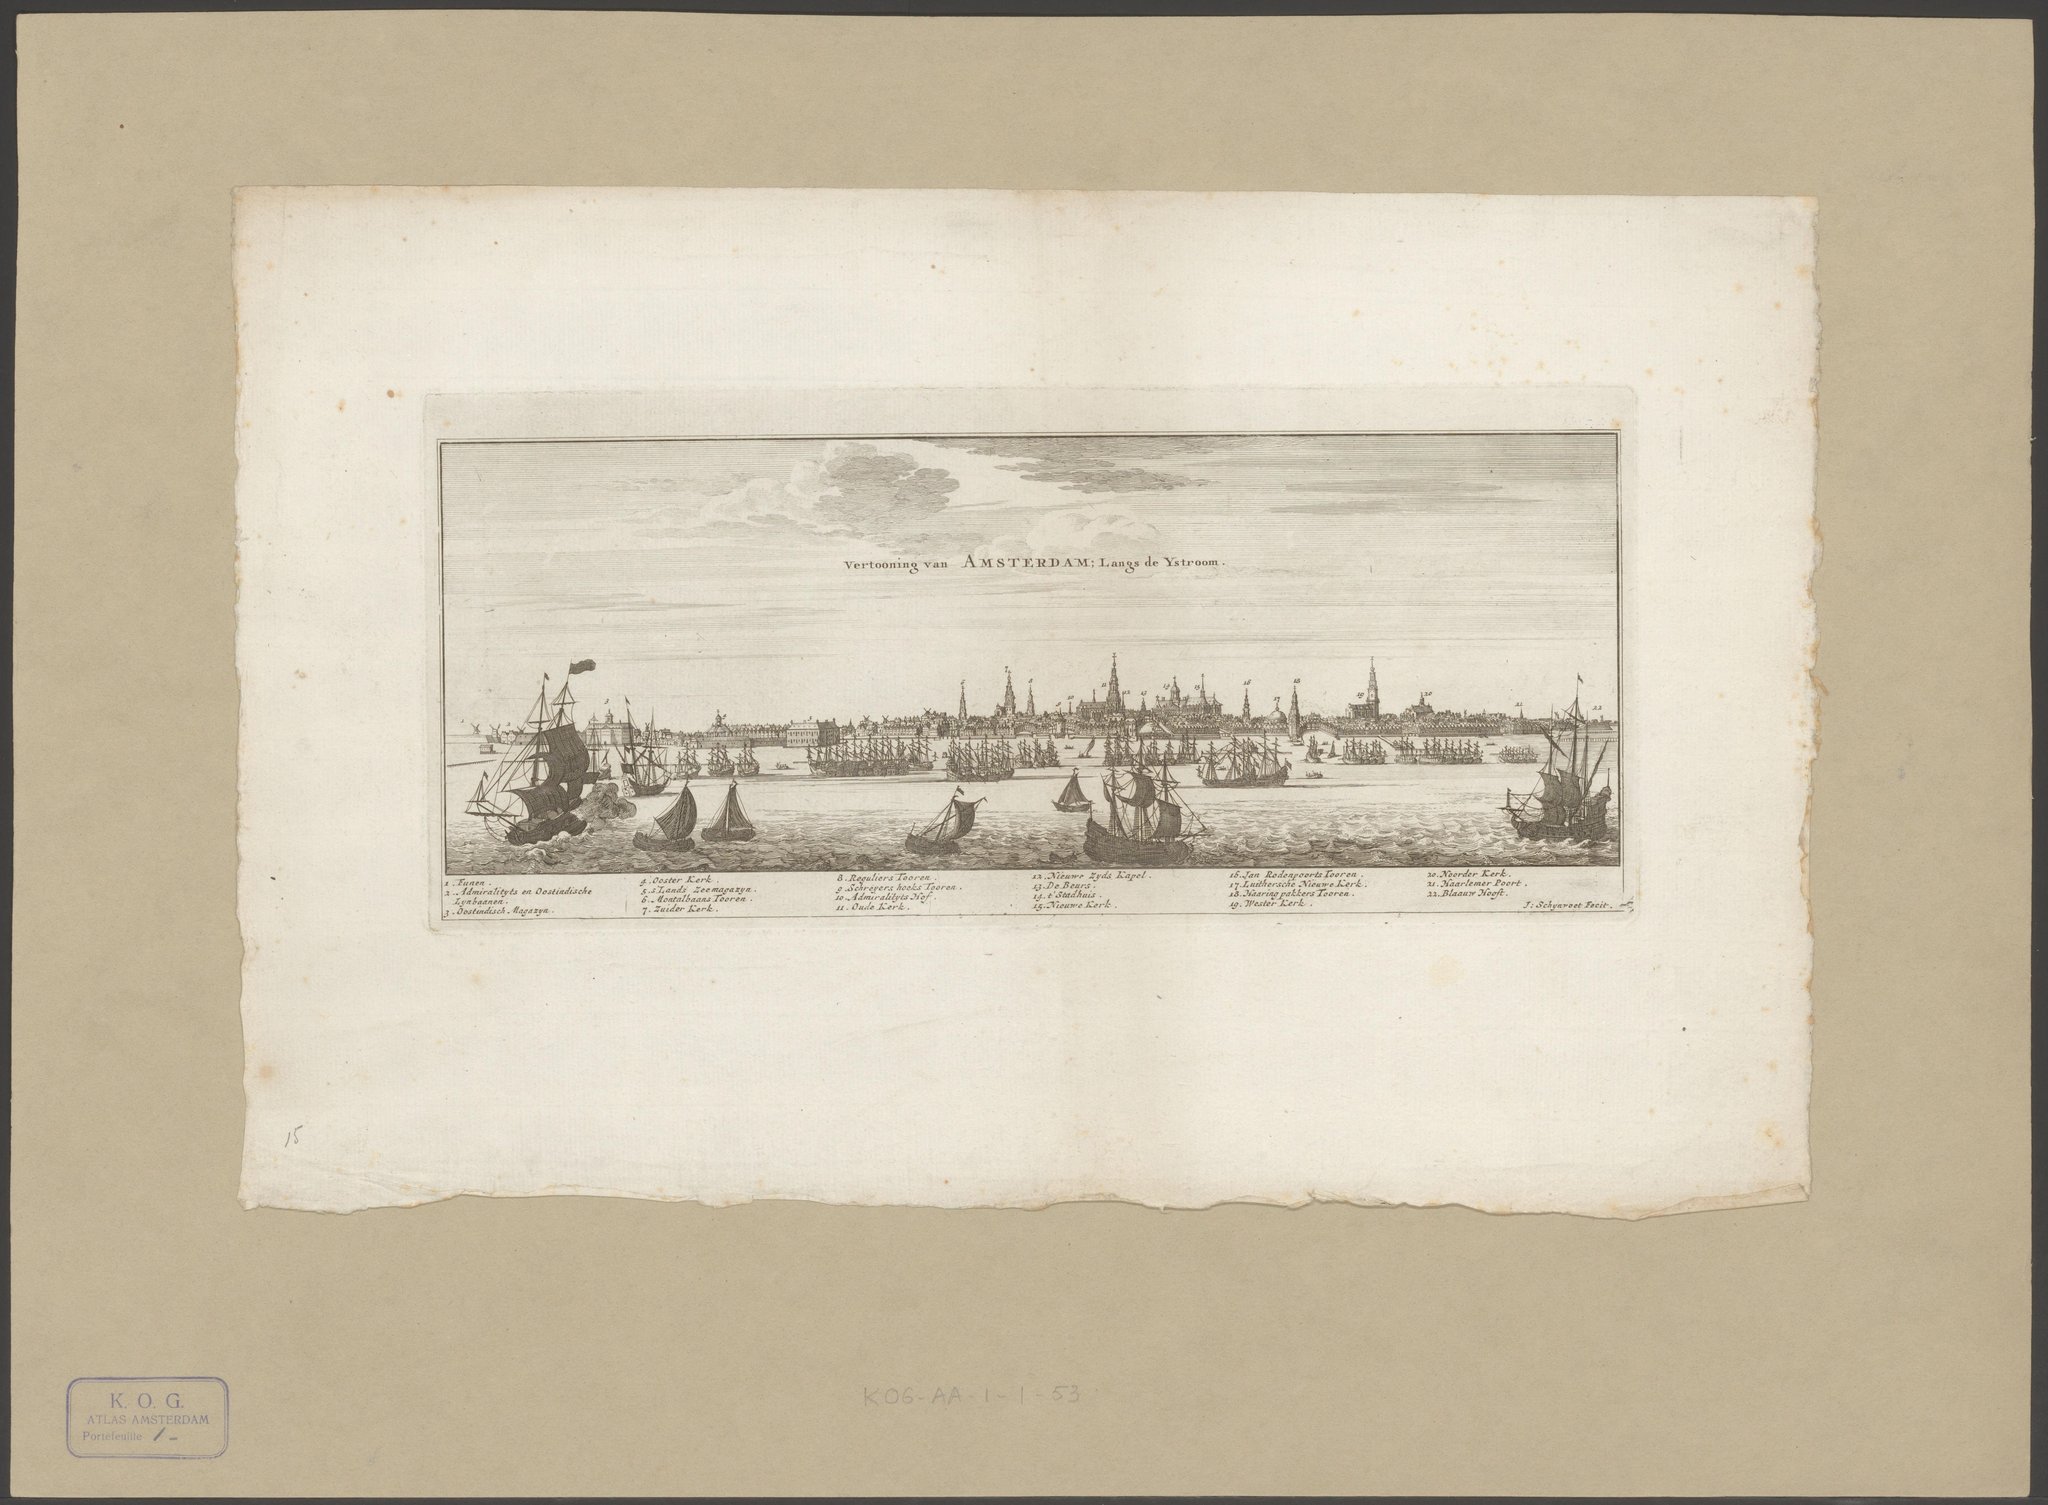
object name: print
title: Vertooning van Amsterdam; Langs de Ystroom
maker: jacobus schijnvoet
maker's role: draughtsman, print maker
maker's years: 1685-1743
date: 1726-1751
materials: paper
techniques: engraving, etching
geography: amsterdam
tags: city-view in general; 'veduta', river, ships (in general) - cc - more than one ship, amsterdam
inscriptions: collector's mark: ‘1’ Lugt 1641b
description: Prent waarschijnlijk uit: Hoorn, Nicolaas ten. Wegwyzer door Amsterdam, Zynde eene beknopte verhandeling van desselfs eerste opkomst, vergrootingen, en teegenwoordigen staat (…). Amsterdam: Nicolaas ten Hoorn, 1726. Of uit: Hoorn, Nicolaas ten. Wegwyzer, of korte beschryvinge Van de Stadt Amsterdam, Zynde eene beknopte Verhandeling van desselfs eerste opkomst, vergrootingen, en tegenwoordigen staat (…). Amsterdam: erven J. Ratelband & Co, 1737. Of uit: Hoorn, Nicolaas ten. Wegwyzer of korte beschryvinge der stad Amsterdam. Zynde eene Beknopte Verhandeling van derzelver eerste Opkomst, Vergrootingen en Tegenwoordigen Staat (…). Amsterdam: Pieter Meyer, 1751. Eerdere staat van prent gebruikt in: Hoorn, Nicolaas ten. Wegwyzer door Amsterdam, Zynde eene beknopte verhandeling van desselfs eerste opkomst, vergrootingen, en teegenwoordigen staat (…). Amsterdam: Nicolaas ten Hoorn, 1713.